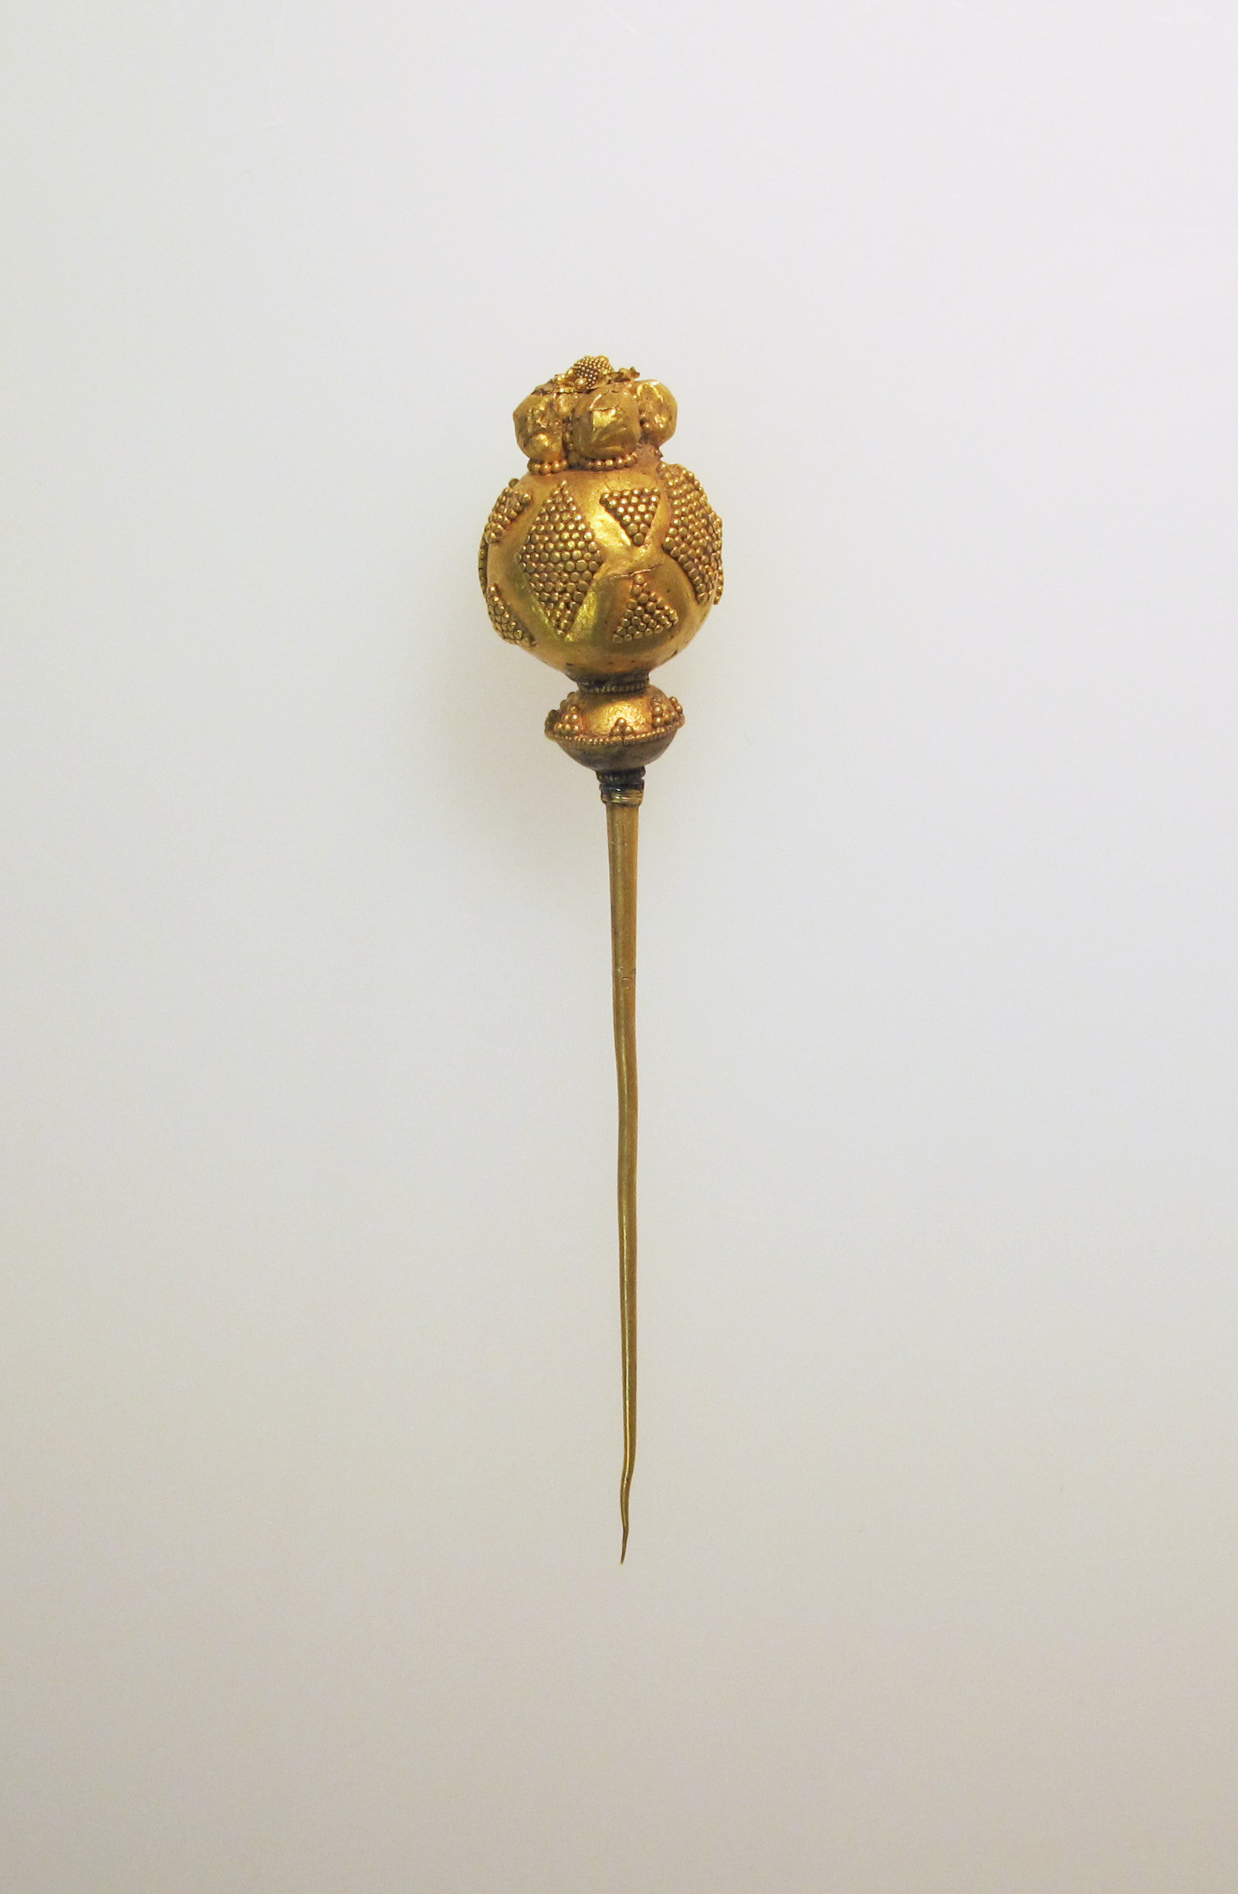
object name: pin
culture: etruscan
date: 700-401 BCE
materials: gold